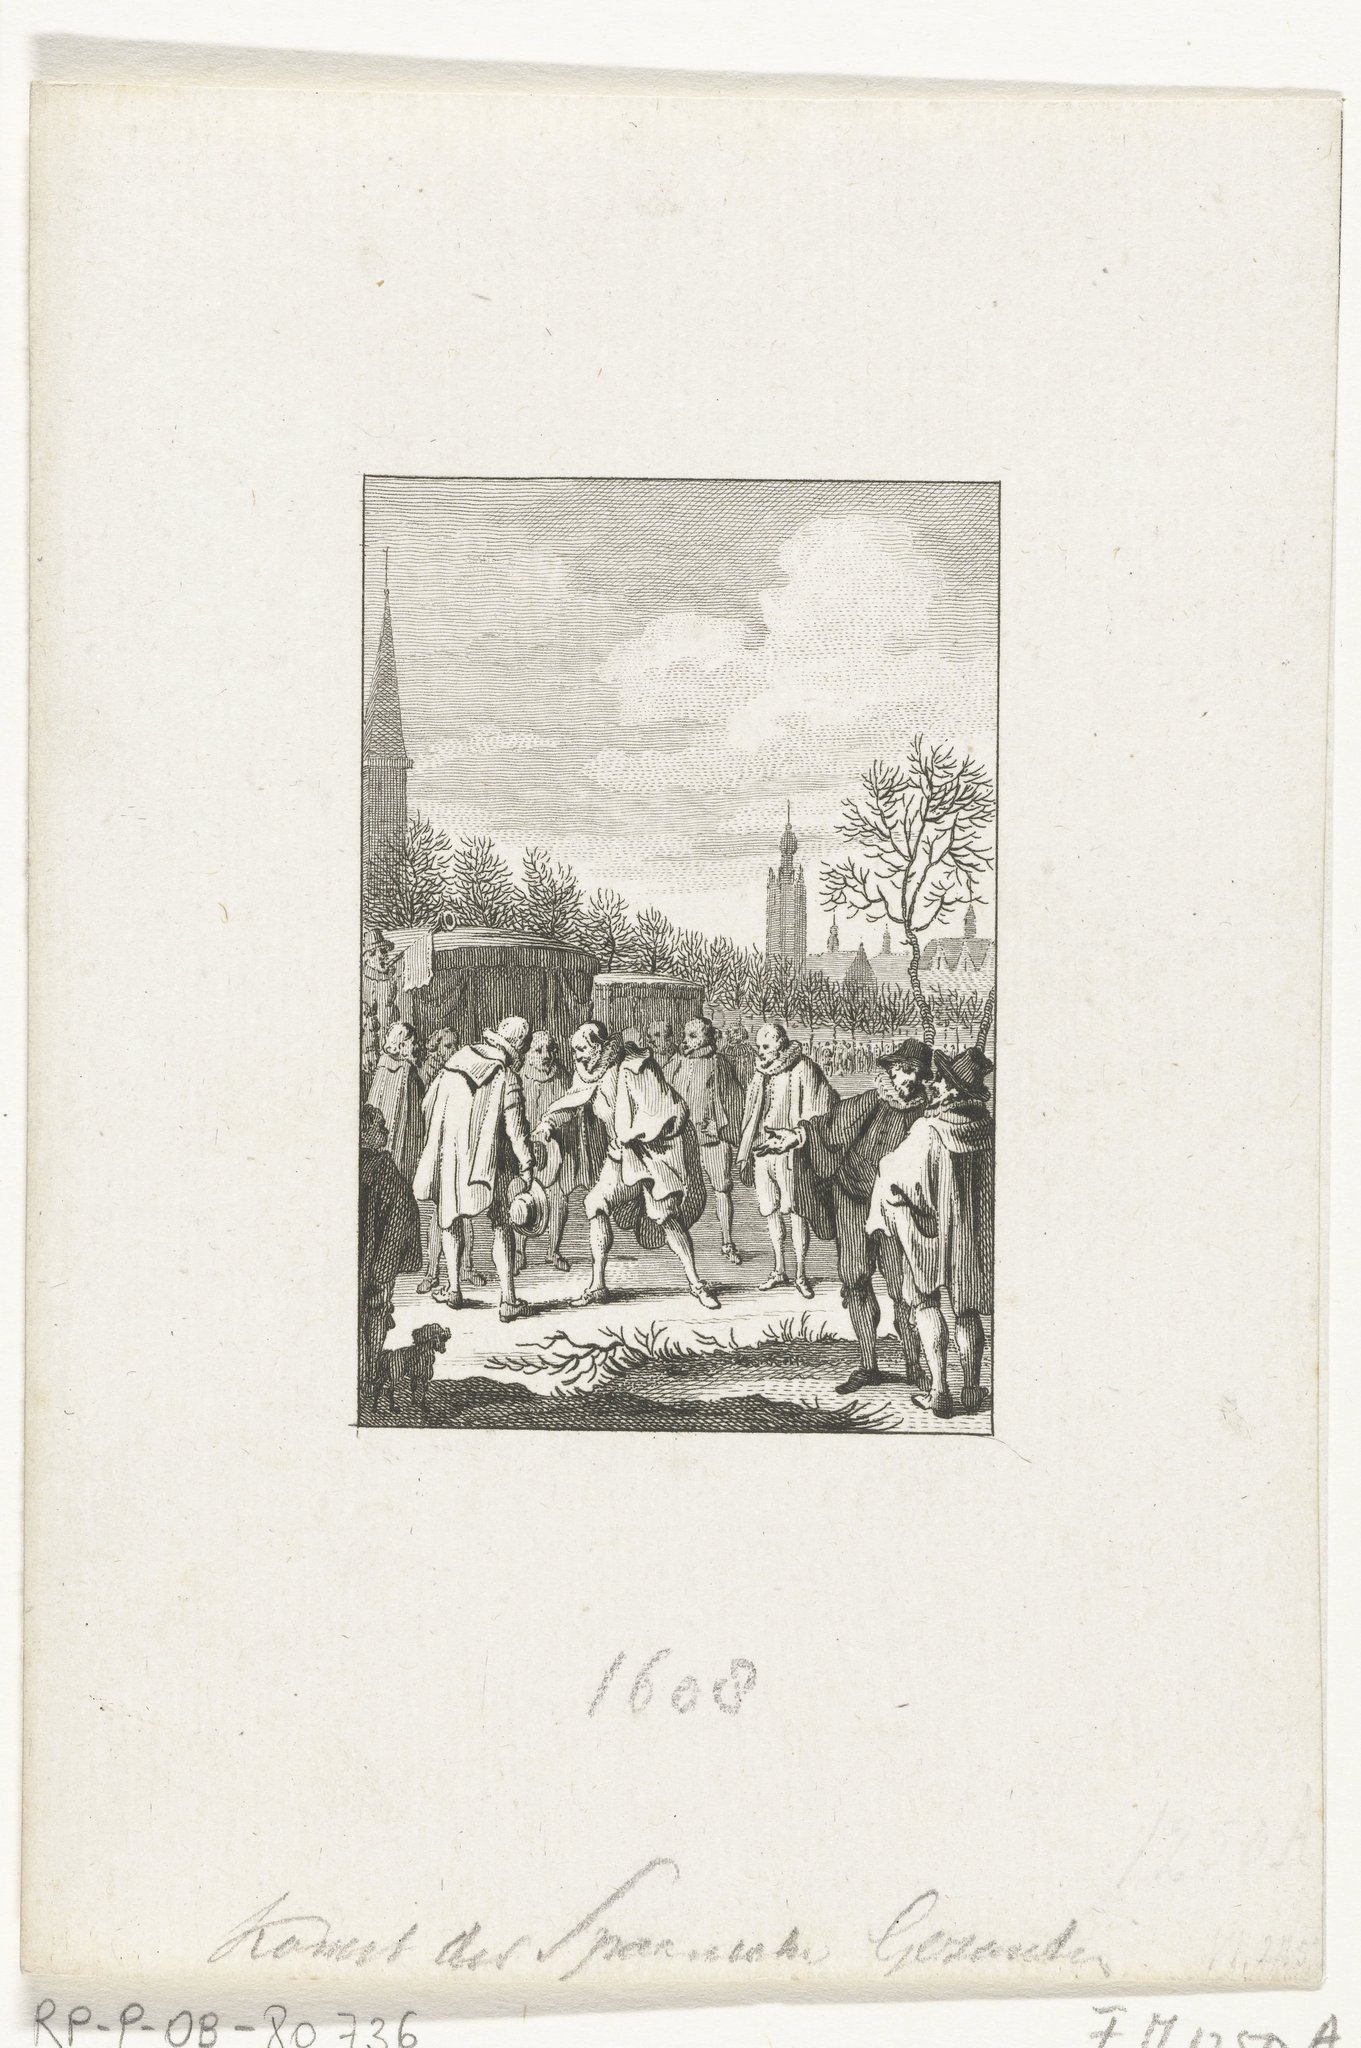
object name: print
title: Aankomst van de Spaanse gezanten te Rijswijk, 1608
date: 1780-1795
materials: paper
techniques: etching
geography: netherlands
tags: the hague, maurice (prince of orange), peace negotiations, meeting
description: Waarschijnlijk gebruikt als illustratie in: J. Fokke, Geschiedenissen der Vereenigde Nederlanden voor de vaderlandsche jeugd, Johannes Allart, Amsterdam 1783-1795, 25 delen, dl. VI, pl. VI. Staat vóór de letter.